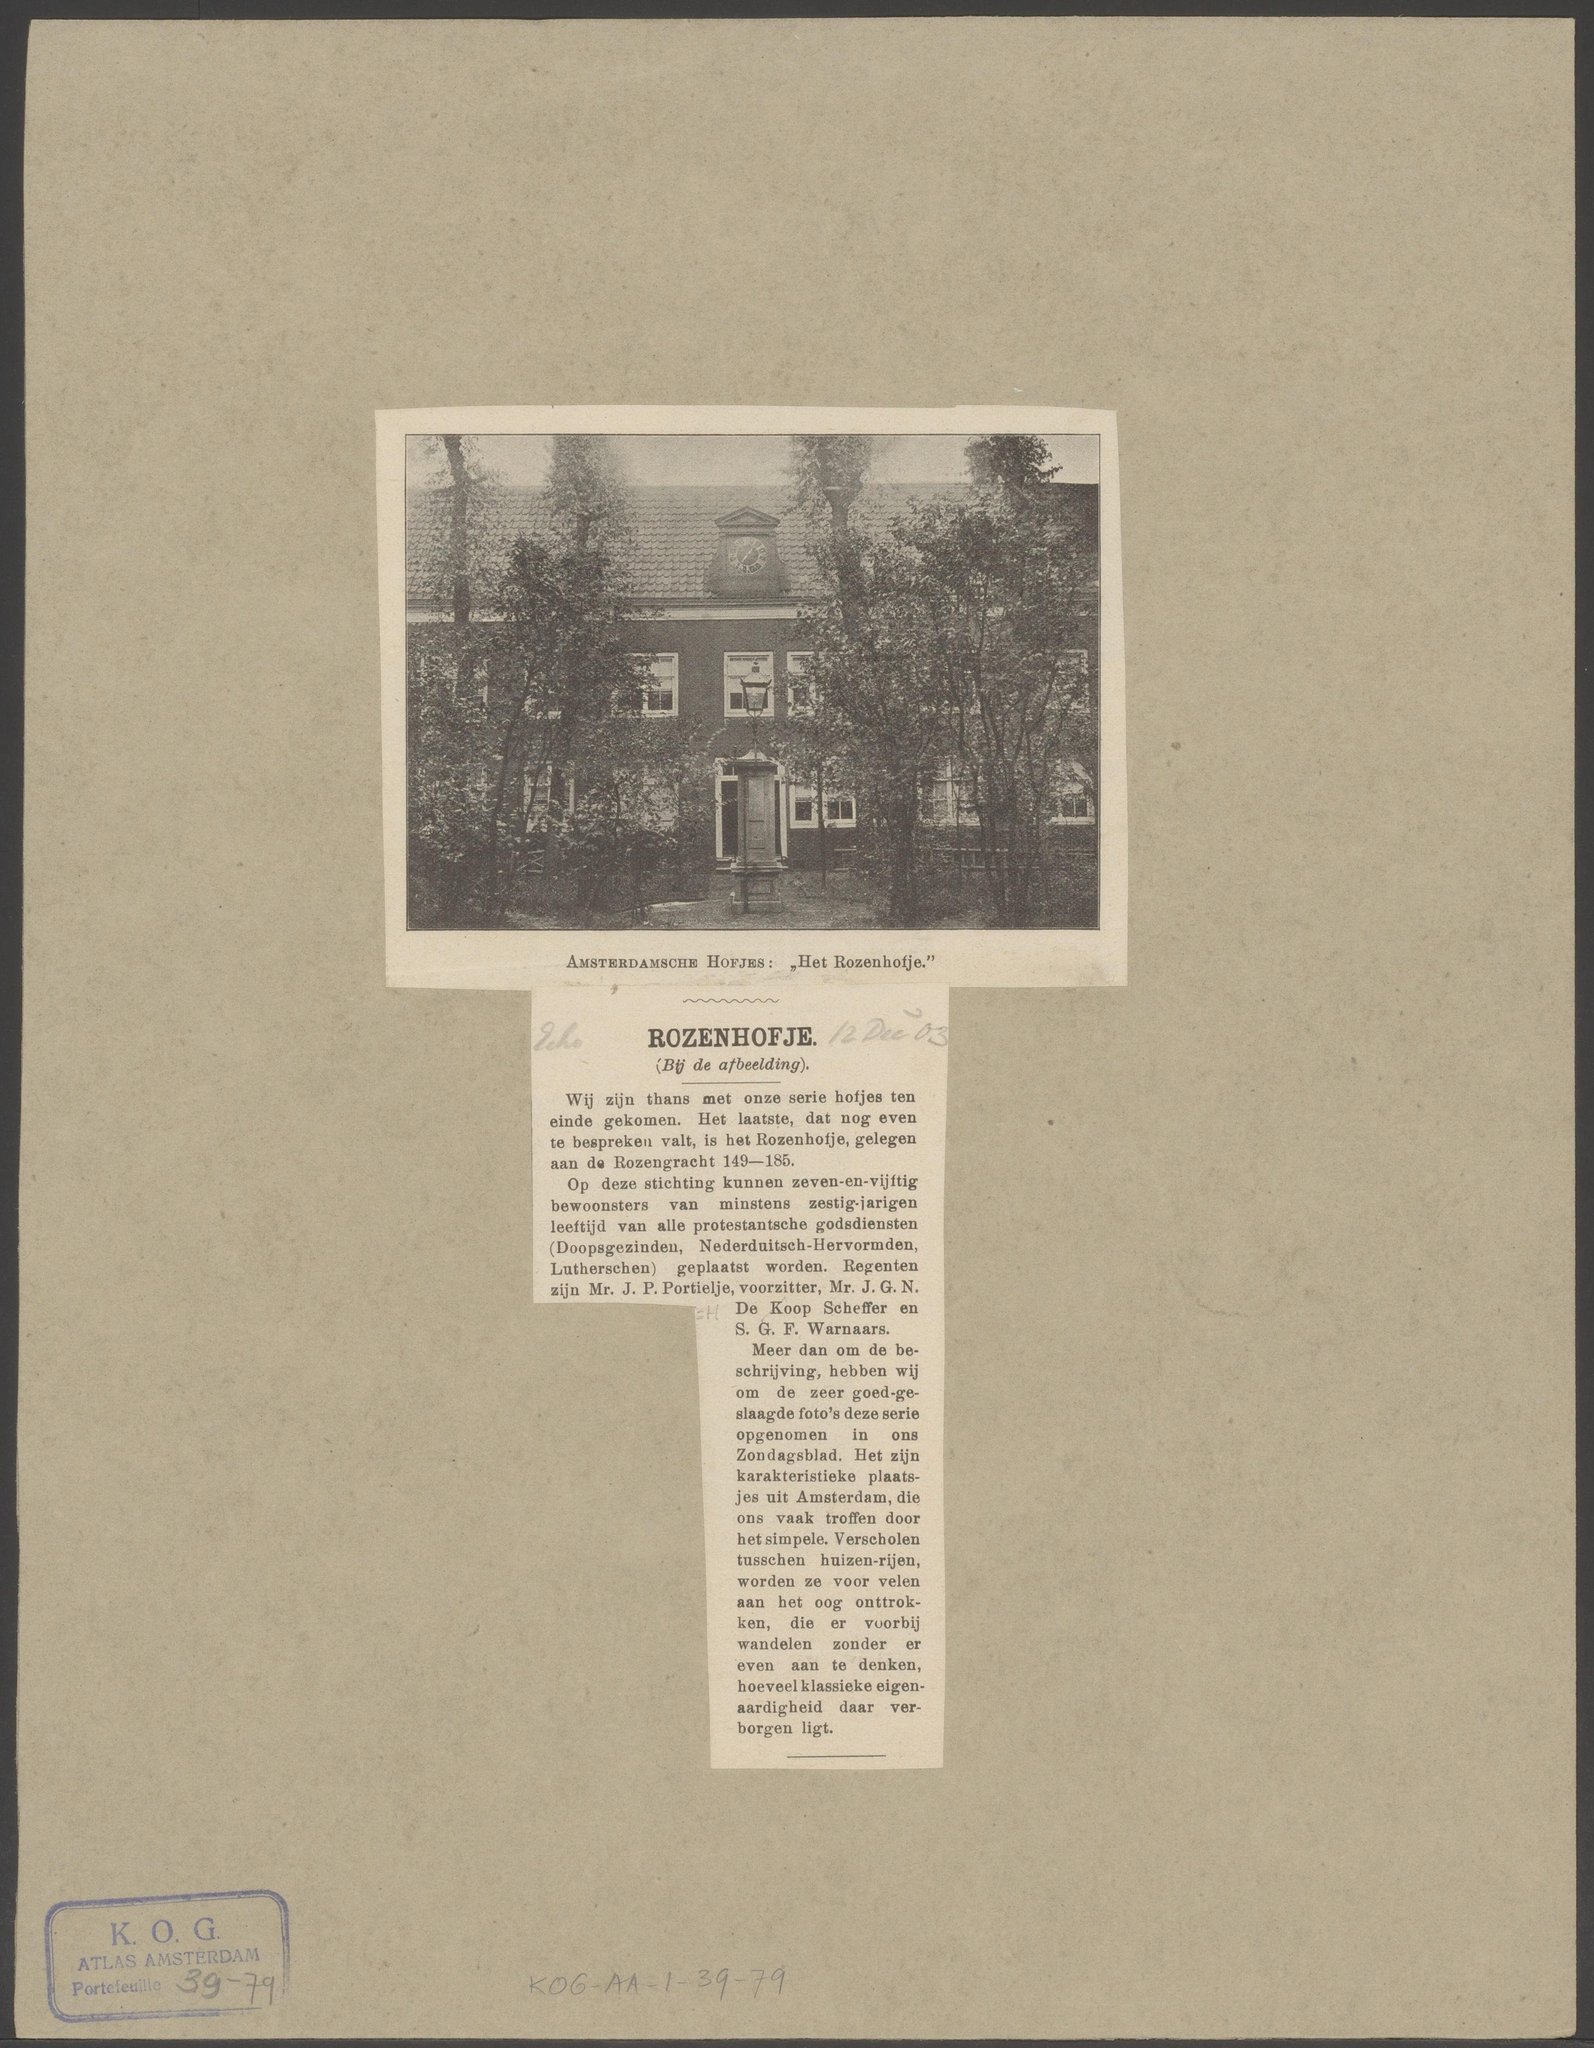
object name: photomechanical print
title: Amsterdamsche Hofjes: "Het Rozenhofje" / Rozenhofje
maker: Anonymous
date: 1903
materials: paper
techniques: letterpress printing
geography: netherlands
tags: alms-house (dutch: 'hofje'), courtyard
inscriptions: collector's mark: Lugt 1641b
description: Object bestaat uit twee aan elkaar geplakte bladen. Onderwerpsrubriek binnen de Atlas Amsterdam: Armwezen en liefdadige instellingen: III. Verschillende gestichten en instellingen / Hofjes: 't Roozenhofje - Suykerhofje - St. Andrieshofje.